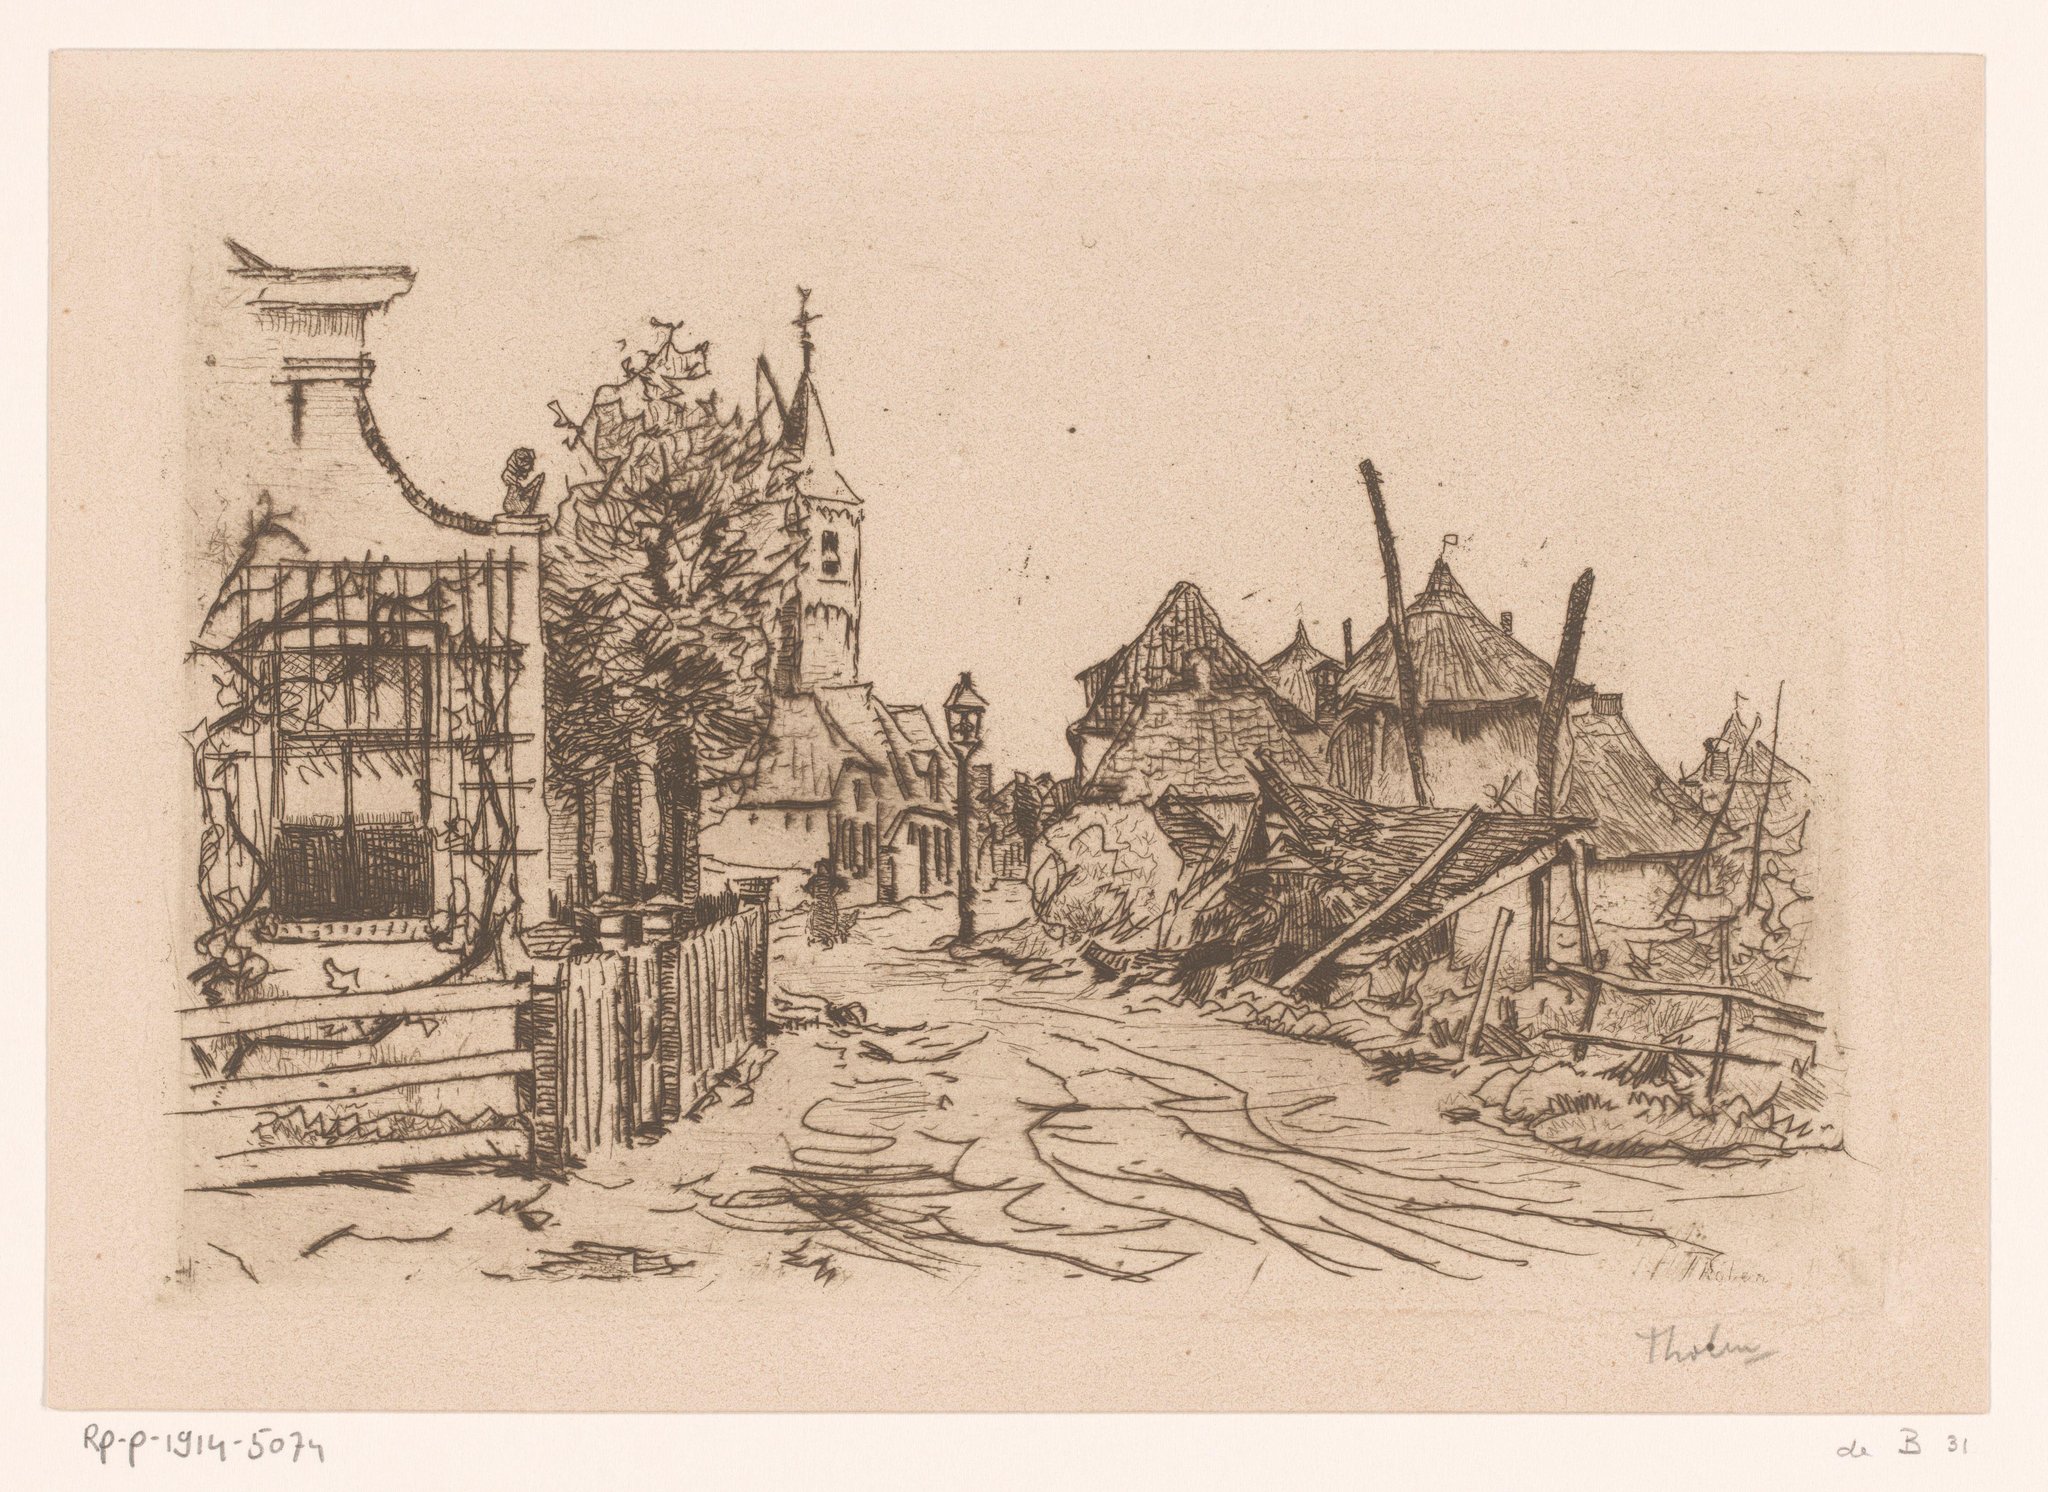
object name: print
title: Dorpsstraat met huizen, kerktoren en hooiberg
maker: willem bastiaan tholen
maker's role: draughtsman, painter, print maker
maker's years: 1860-1931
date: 1870-1914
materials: paper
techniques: etching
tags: village street, church (exterior)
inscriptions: collector's mark: Lugt 2233